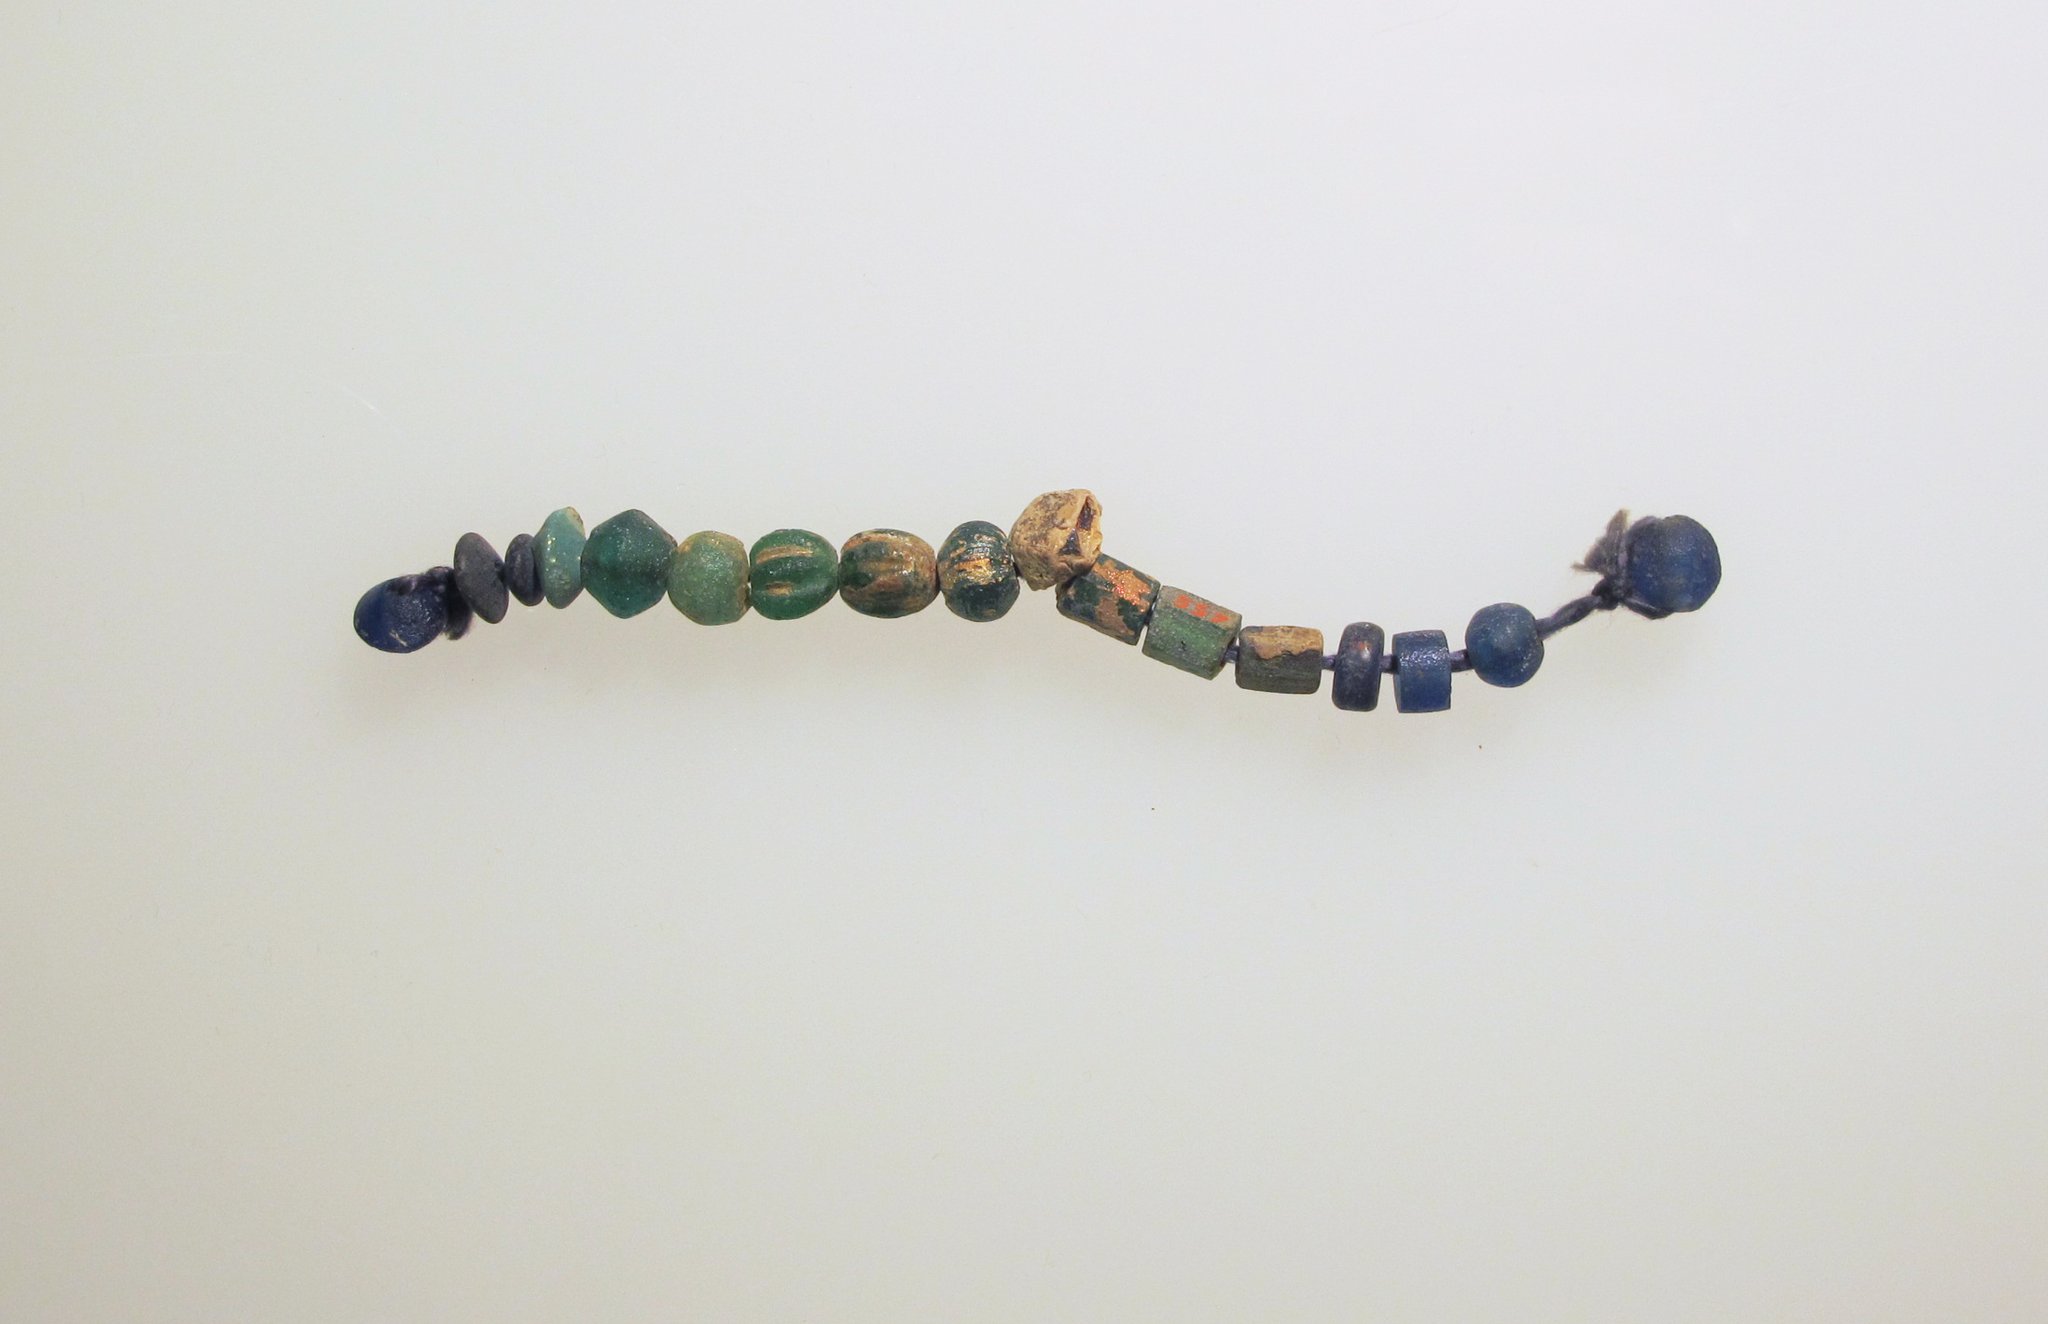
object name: bead, 17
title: Beads, 17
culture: roman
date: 670 BCE-330 CE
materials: glass